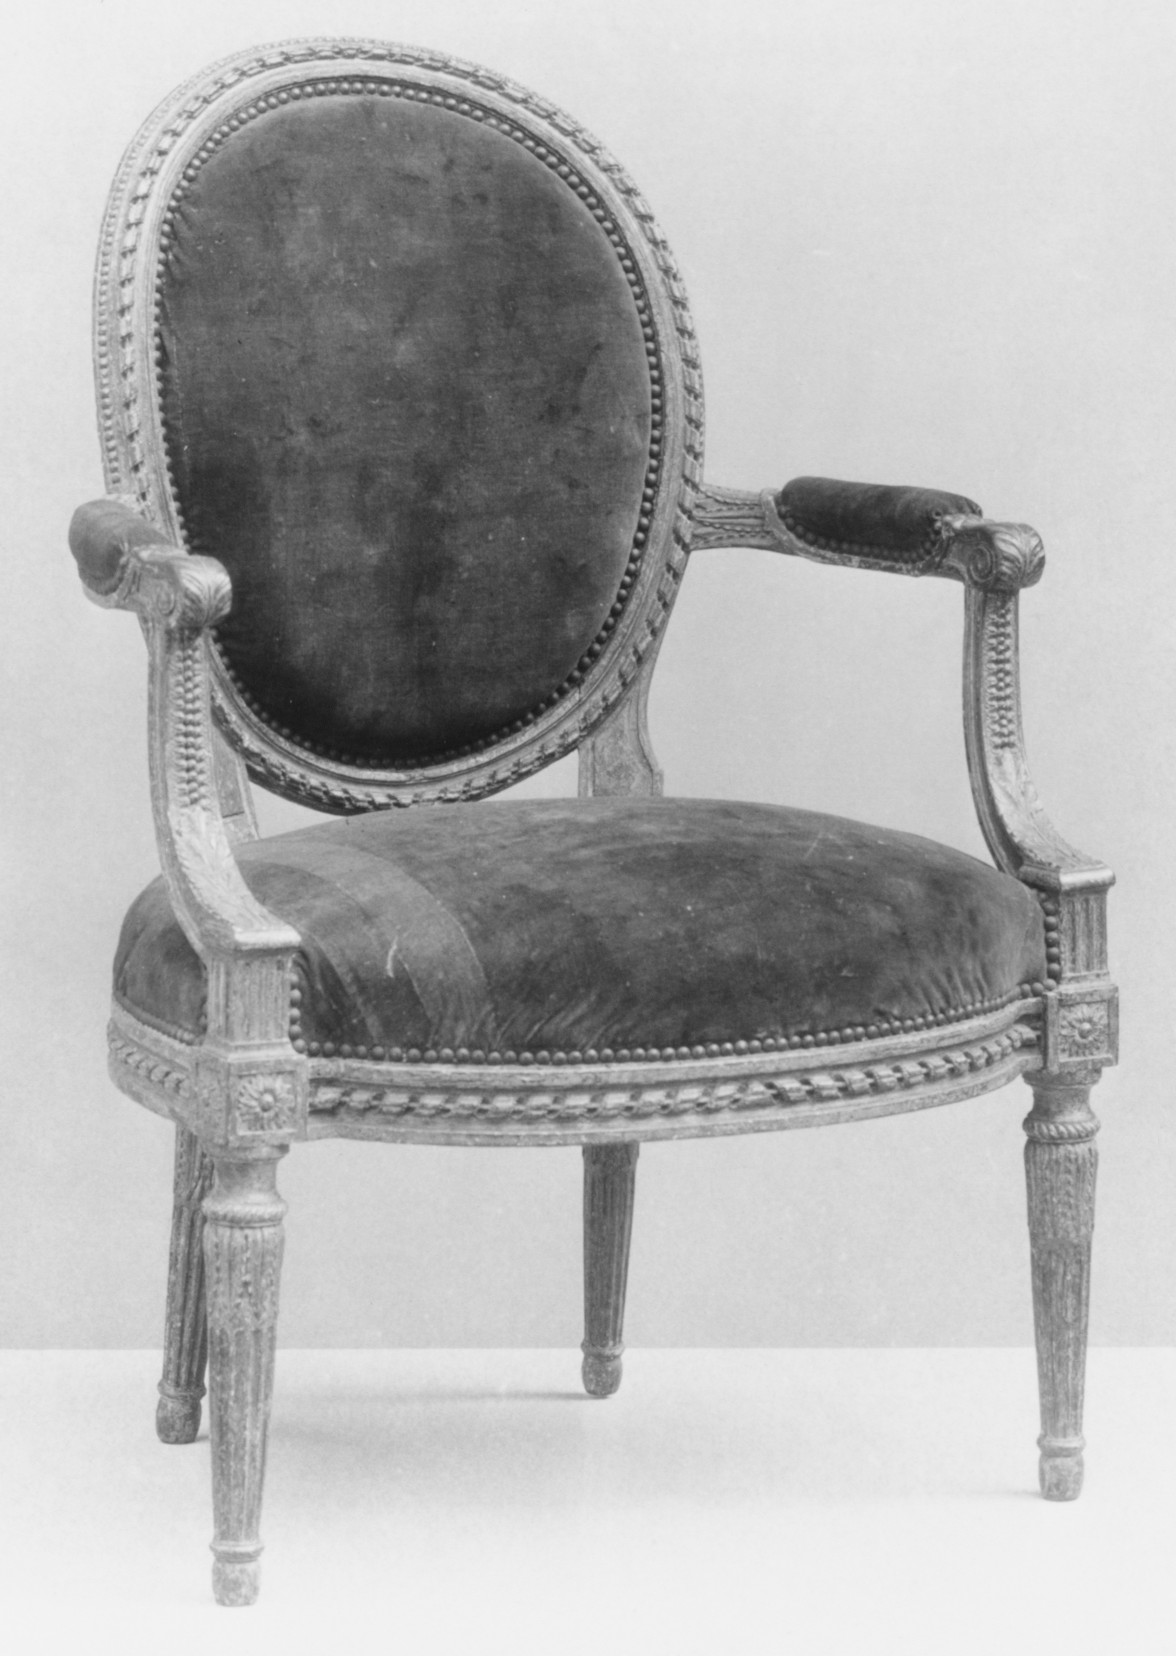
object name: armchair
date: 1785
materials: wood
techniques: carving, gilding